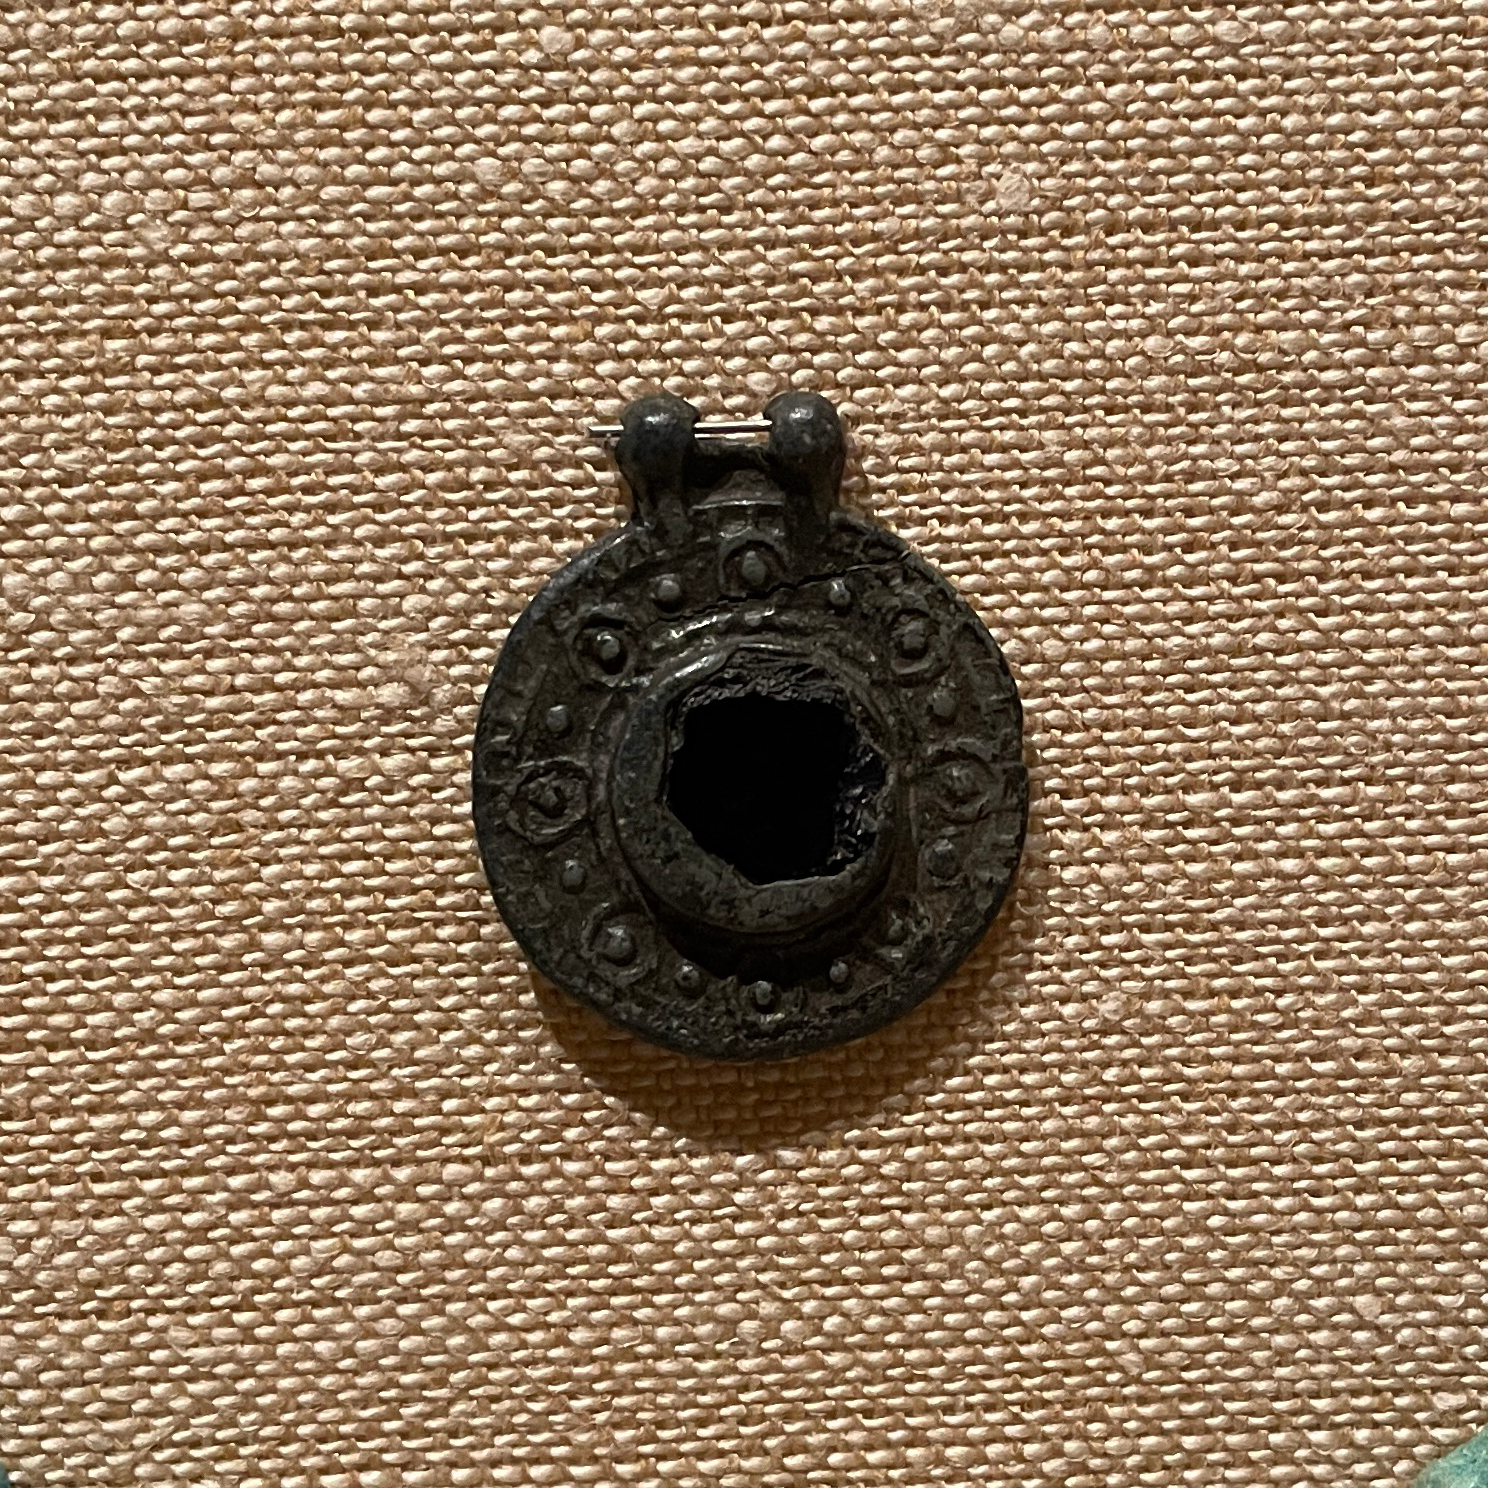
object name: pendant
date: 801-1000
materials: lead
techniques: casting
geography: iran